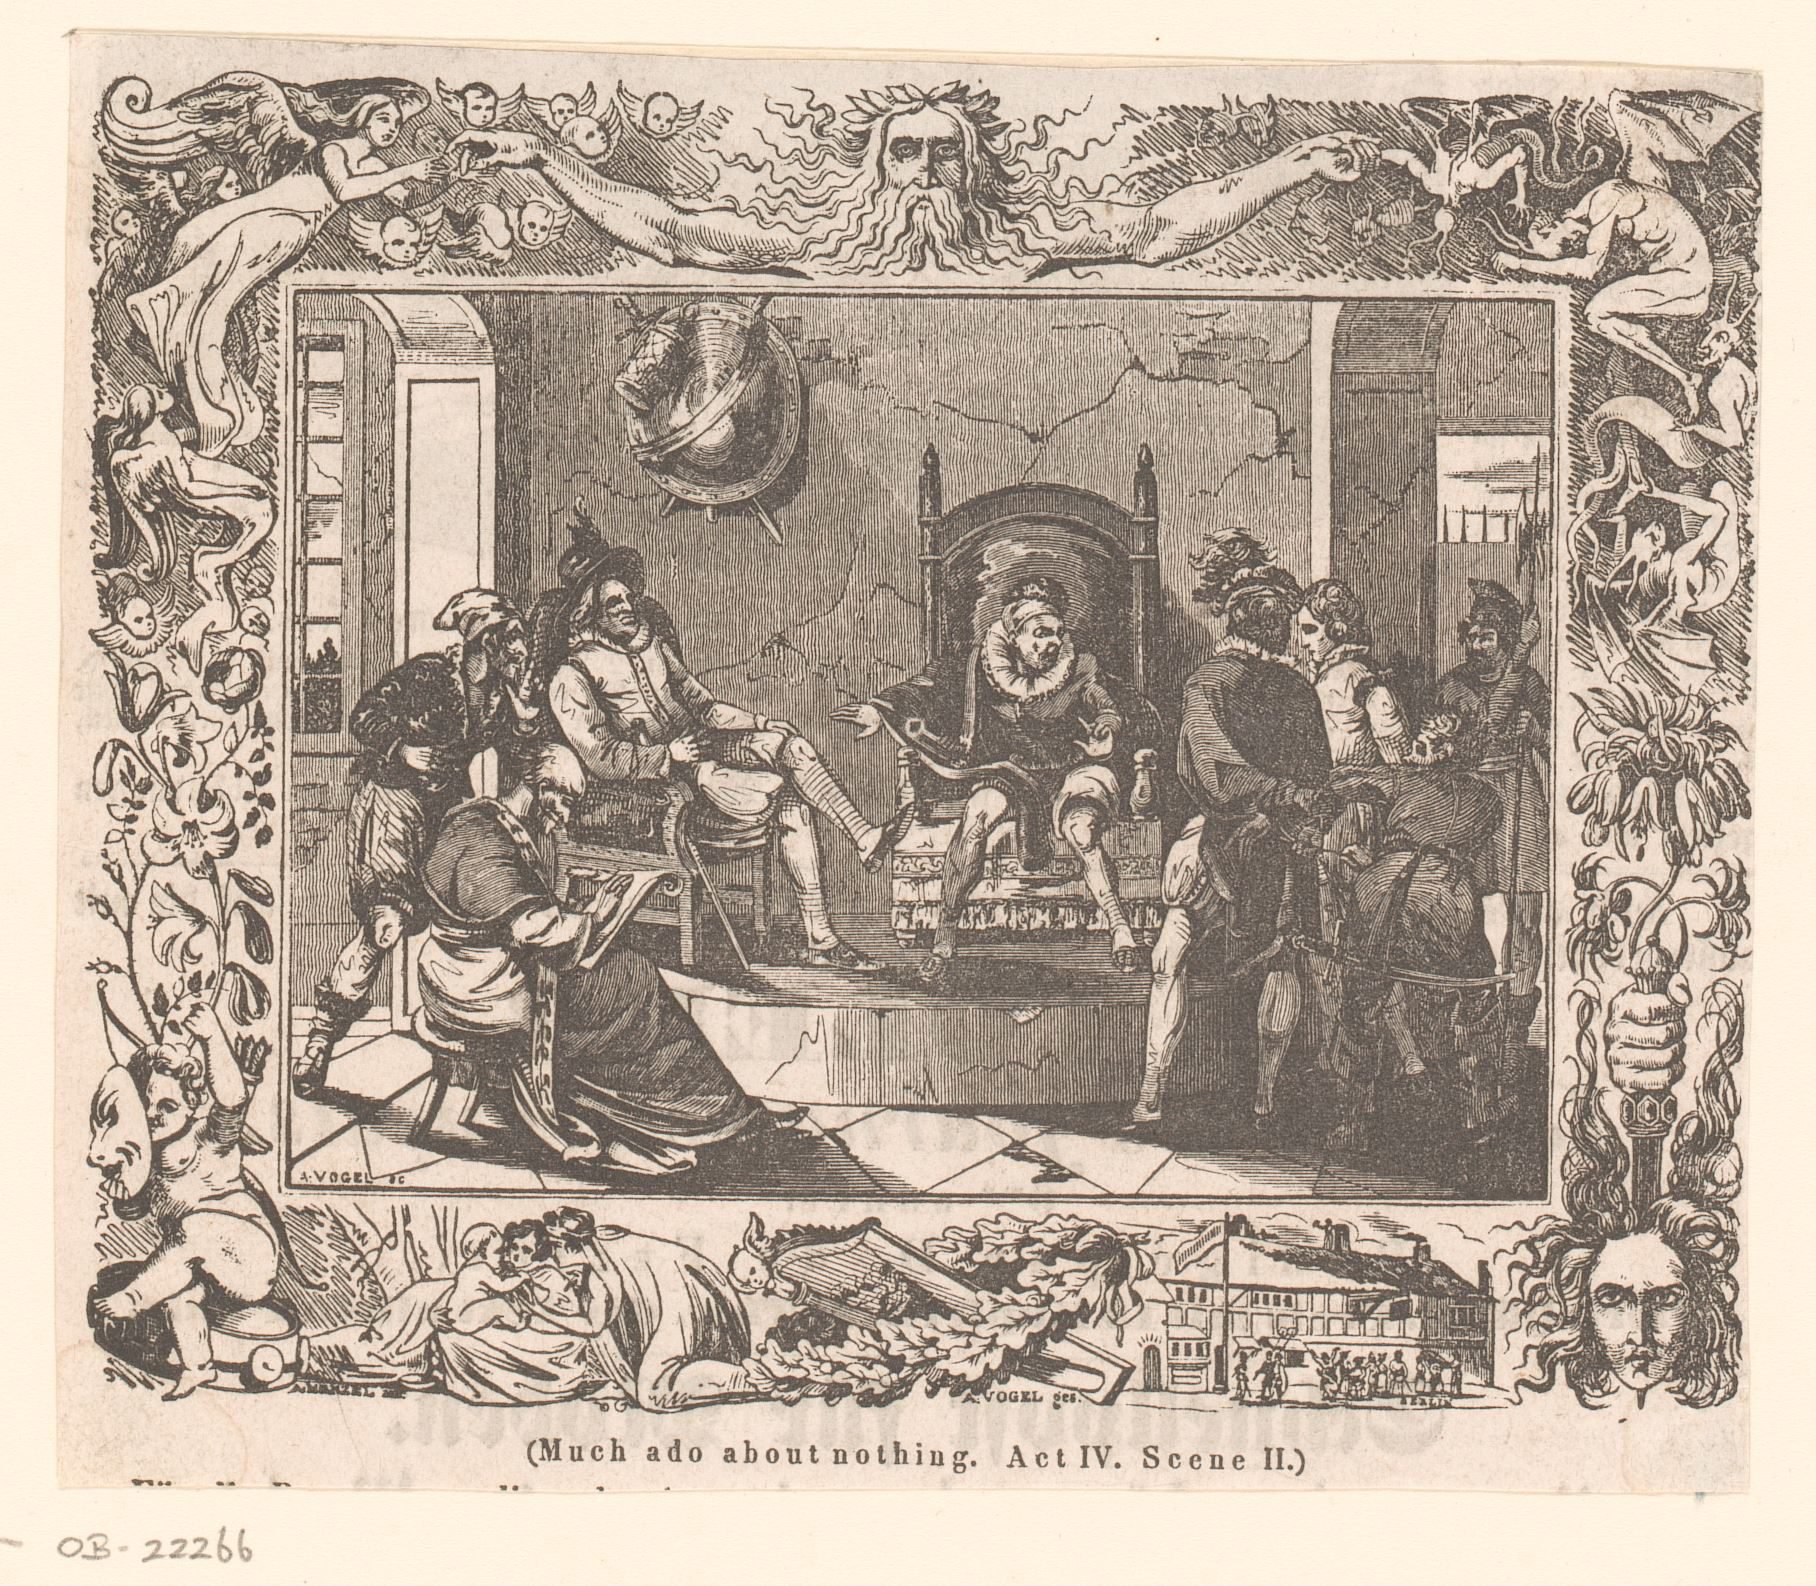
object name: print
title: Vorst in discussie met toehoorders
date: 1824-1886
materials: paper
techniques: engraving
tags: specific works of literature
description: Scène uit Shakespeare's toneelstuk "Much Ado about Nothing" (Act IV. Scene II), in een ornamentale omlijsting naar een ontwerp van Adolf Menzel.